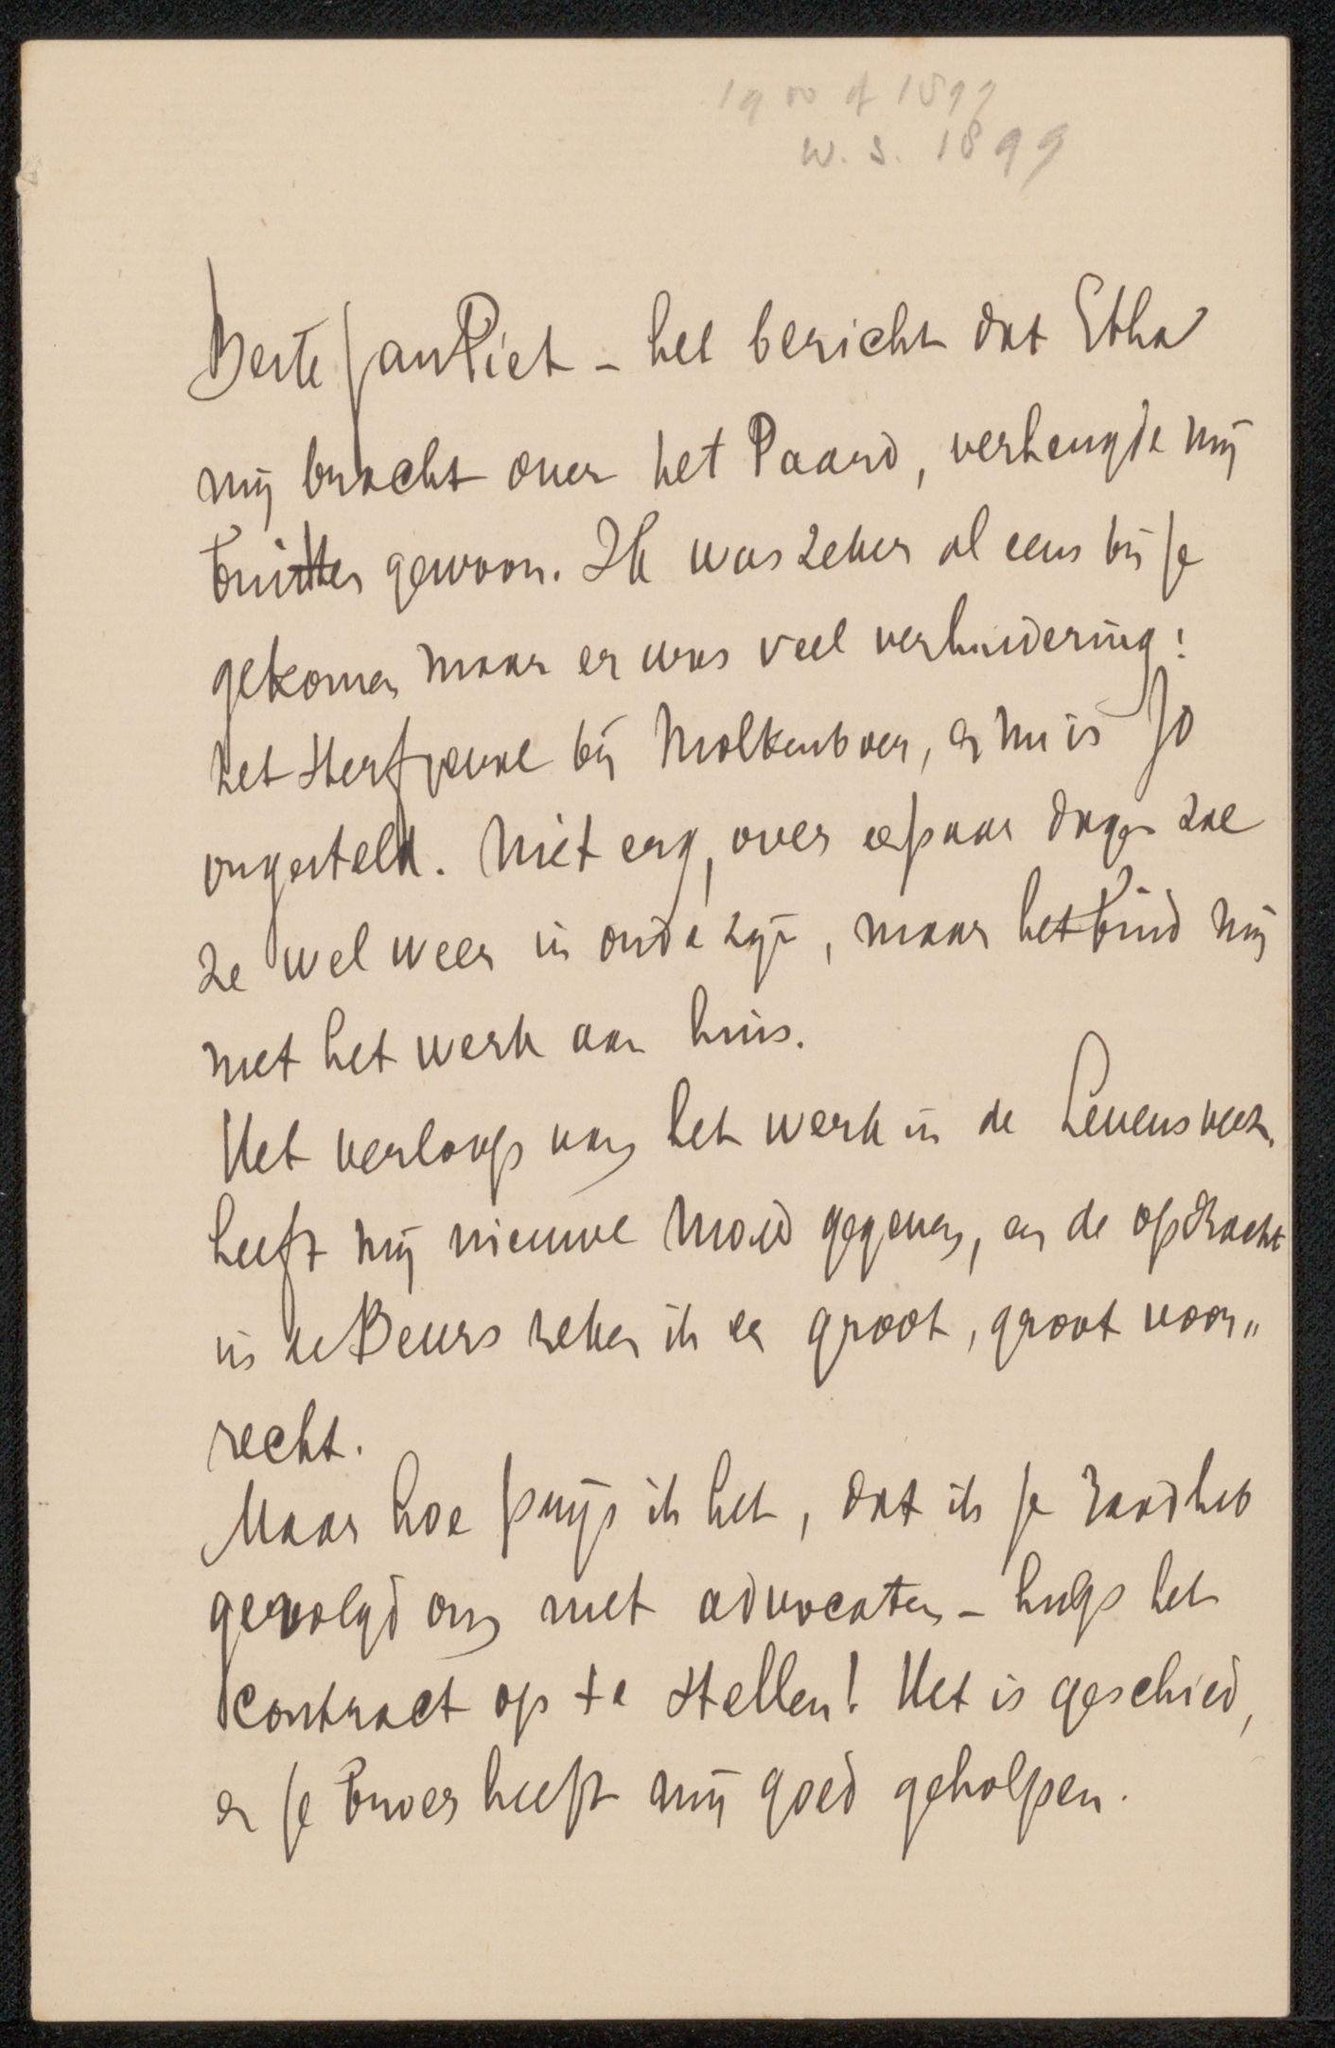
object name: letter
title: Brief aan Jan Veth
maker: antoon derkinderen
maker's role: draughtsman, painter, print maker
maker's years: 1859-1925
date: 1874-1925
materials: ink, paper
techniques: pen, writing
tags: dordrecht, amsterdam, painter, print maker, draughtsman, designer, jan veth, utrecht, etha fles, hendrik petrus berlage, sculptor, giotto de bondone, diseases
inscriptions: collector's mark: ‘RPK’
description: Brief gedateerd 1900 of 1899 in latere hand.